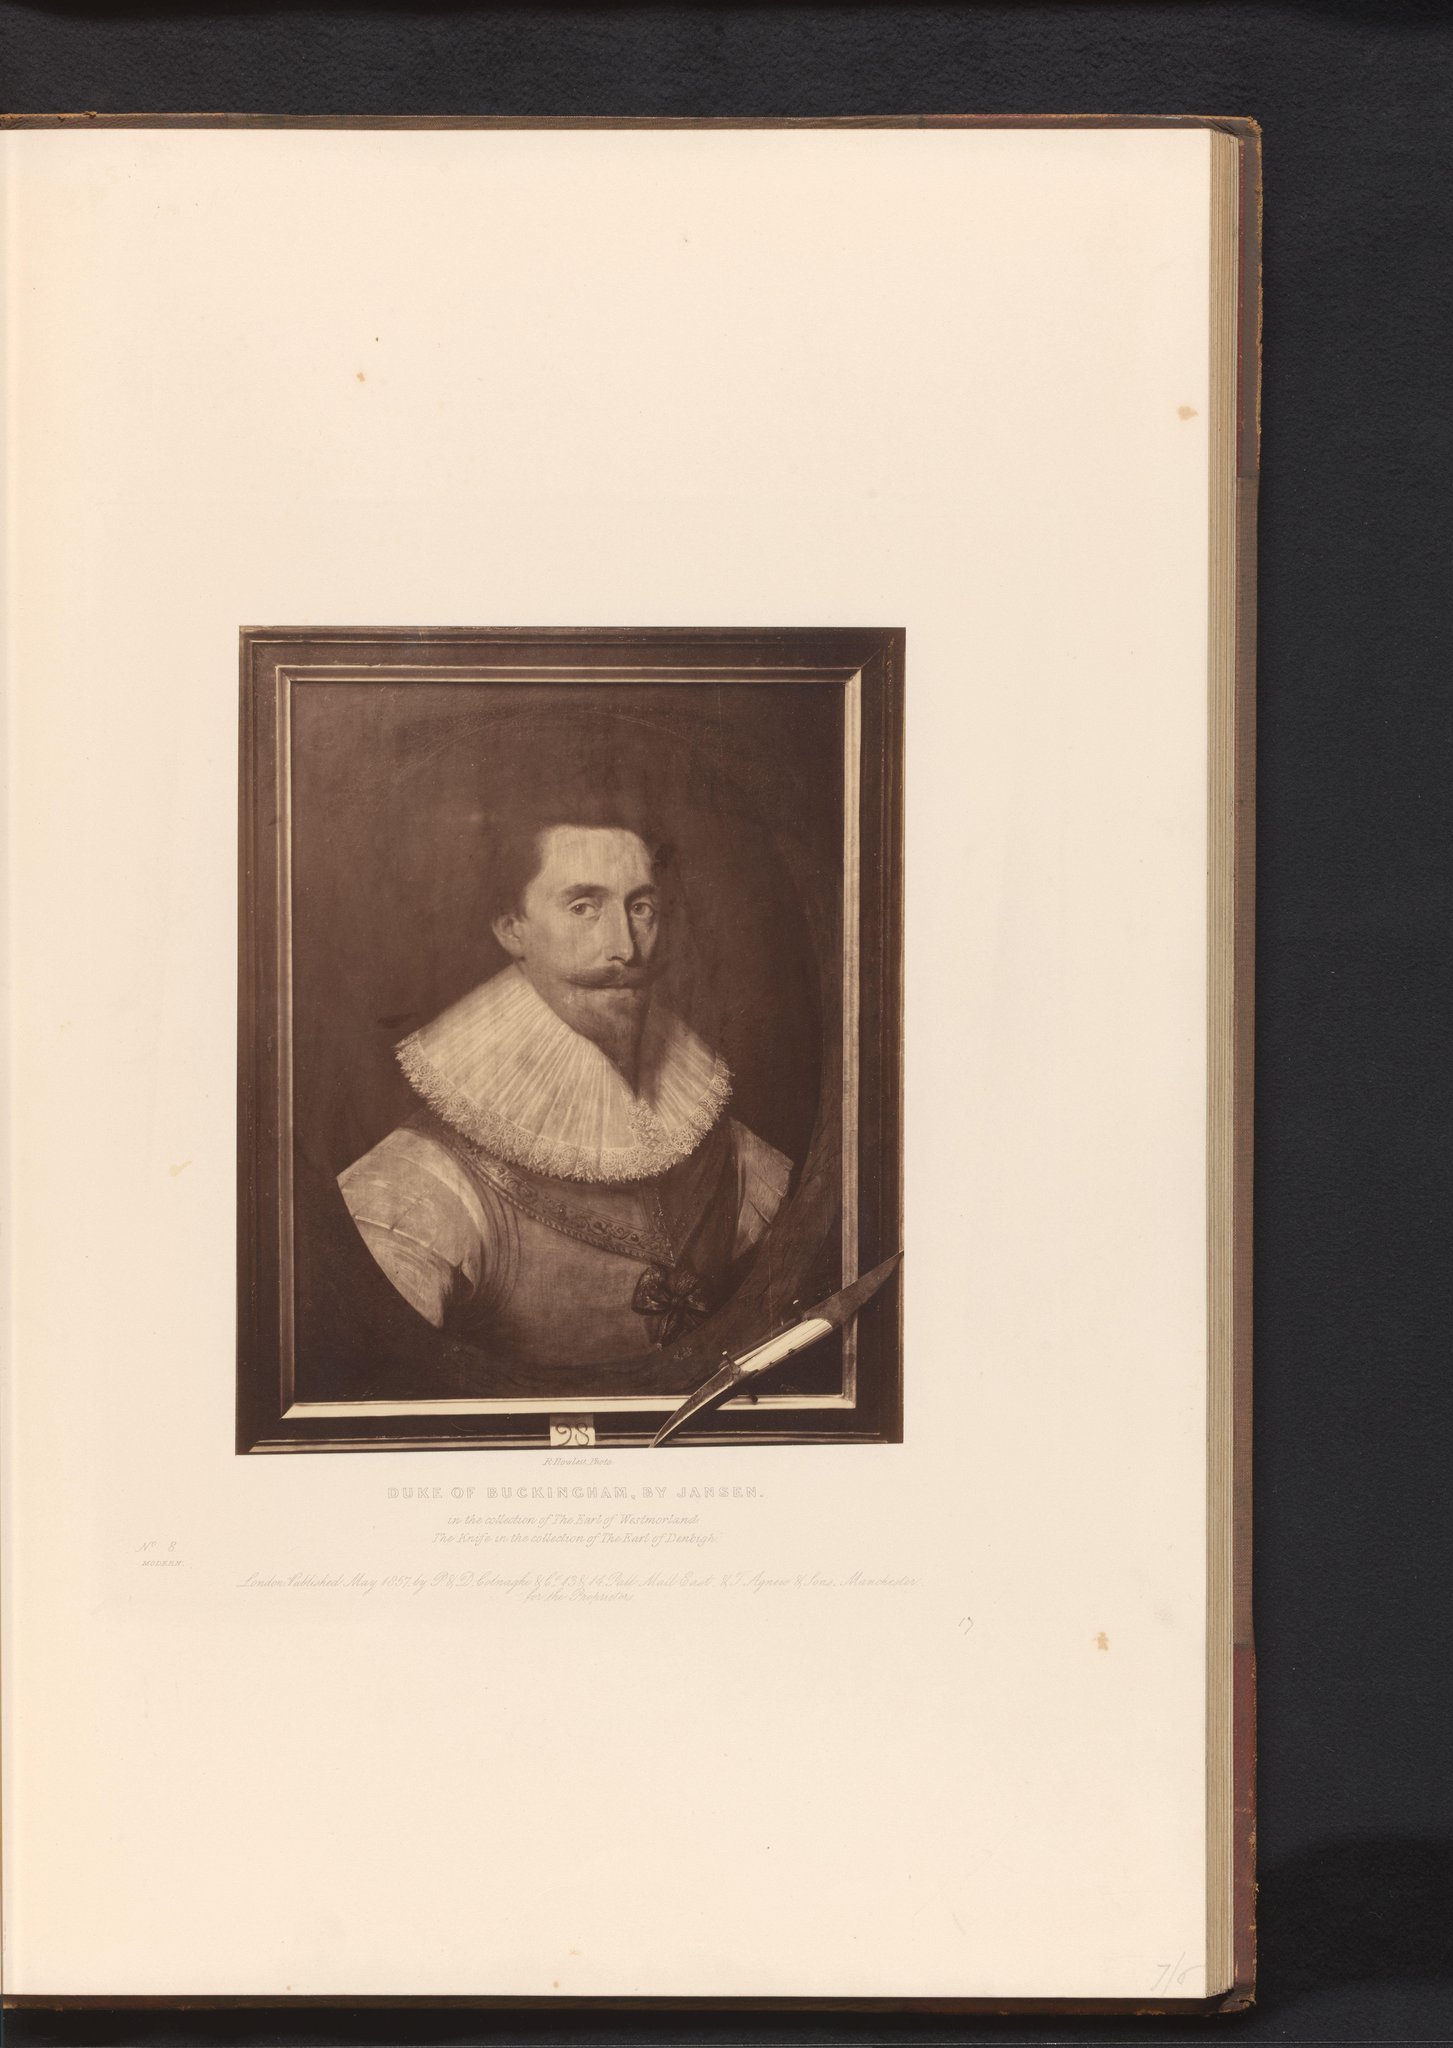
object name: photograph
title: Duke of Buckingham, by Jansen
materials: photographic support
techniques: albumen print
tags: historical persons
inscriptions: number: ‘No. 8./ ANCIENT.’, number: ‘7/6’, number: ‘17’, inscription: ‘In the collection of The Earl of Westmorland./ The Knife in the collection of The Earl of Denbigh./ London, Published May, 1857, by P. & D. Colnaghi & Co, 13 & 14, Pall Mall East & T. Agneur & Sons, Manchester./ For the Proprietors.’